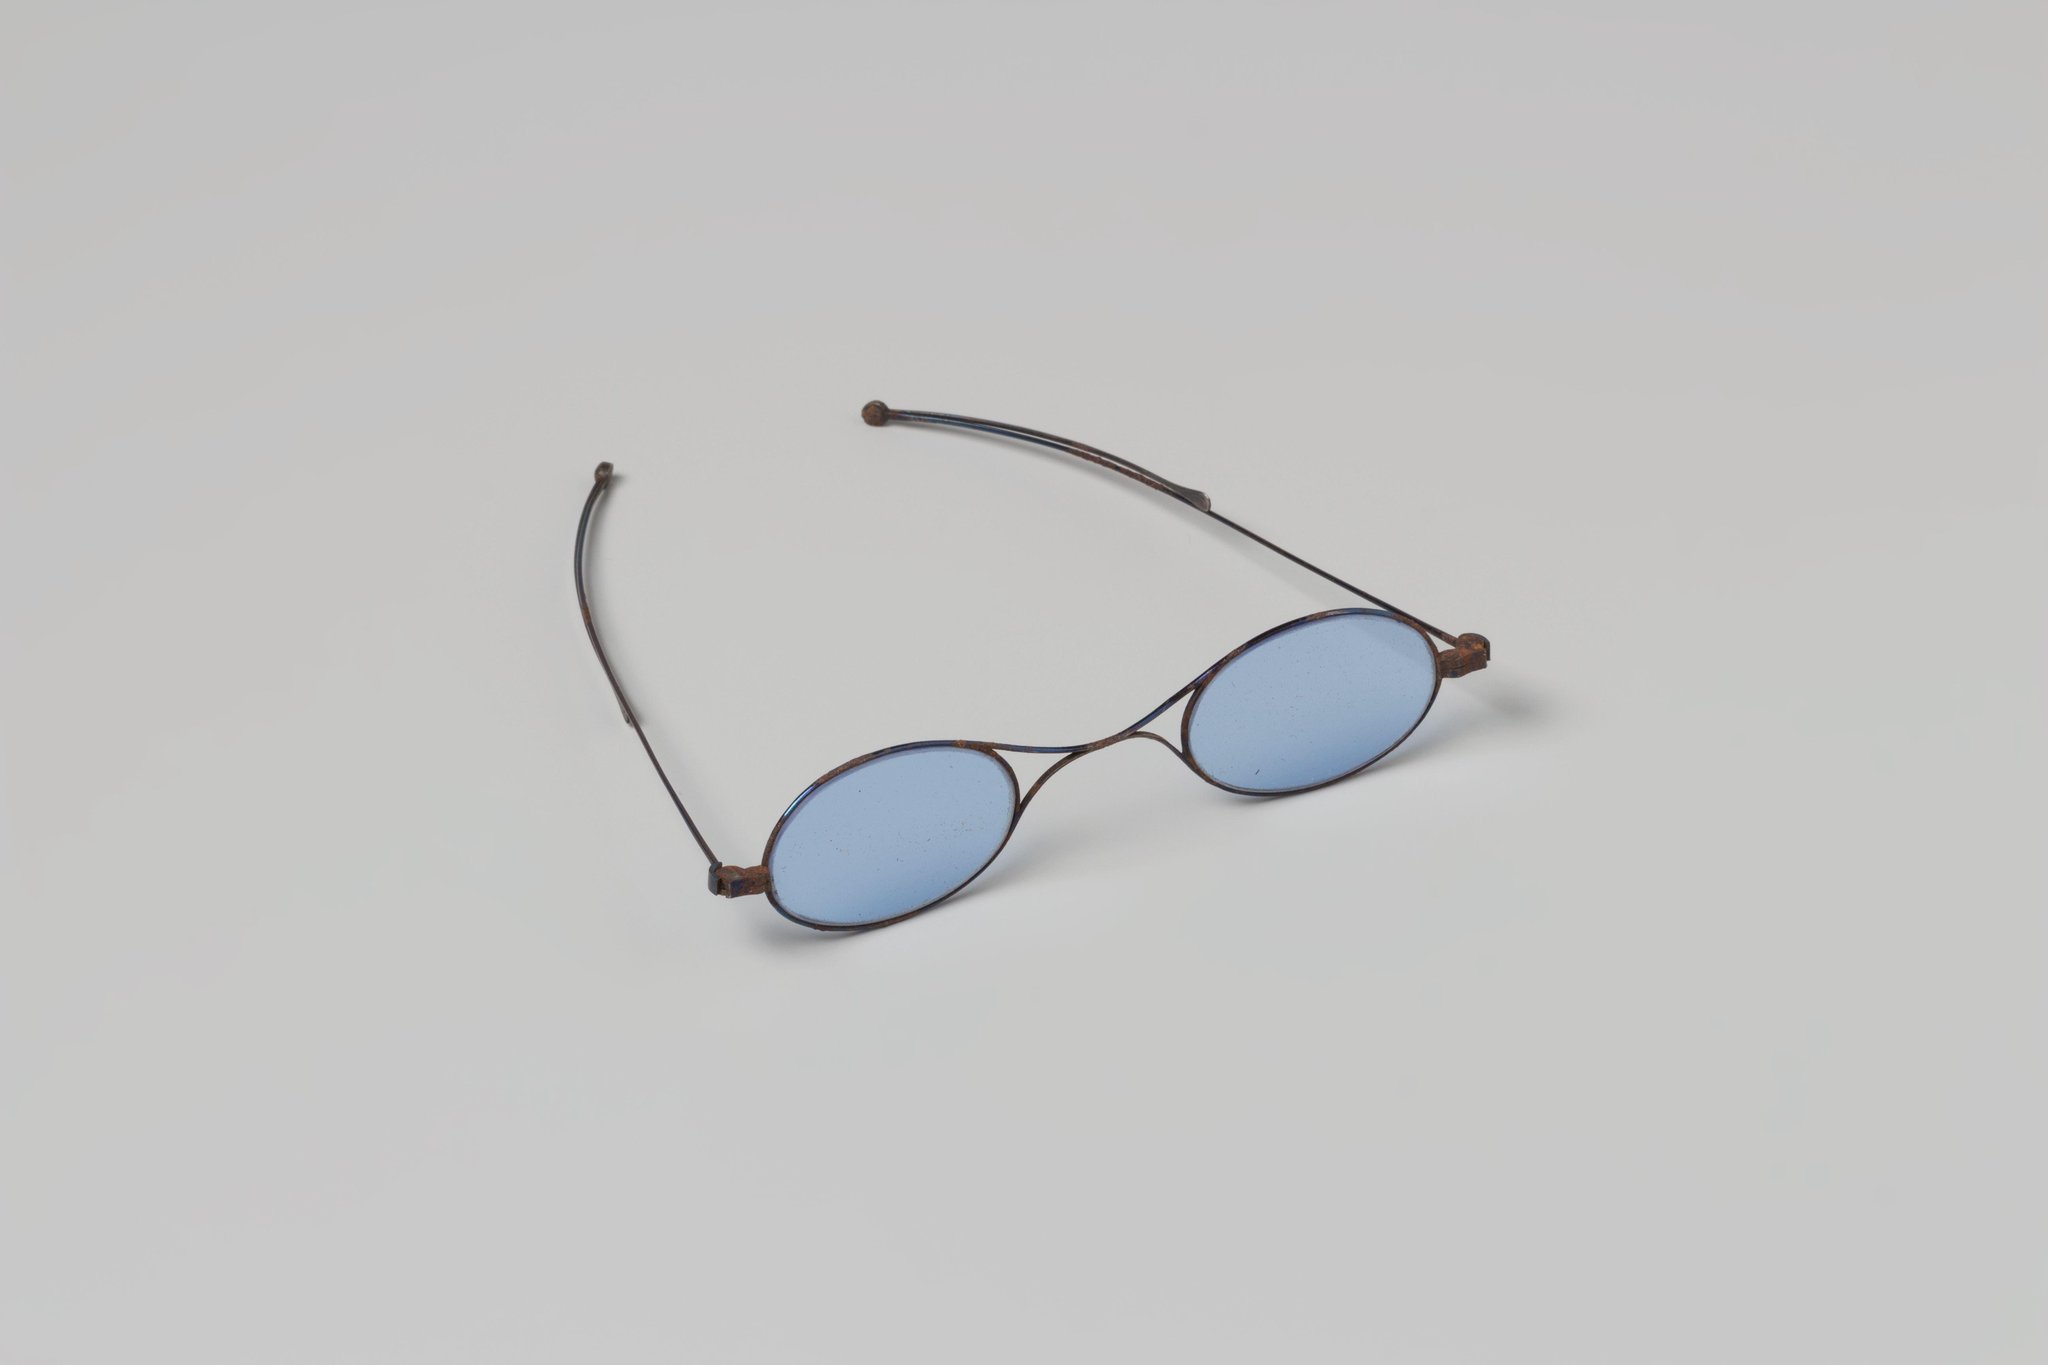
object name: spectacle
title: Bril van blauw staal met ovale blauwe brillenglazen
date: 1830-1860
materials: glass, steel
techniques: forging, grinding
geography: amsterdam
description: Bril met ovale blauwe glazen in blauw stalen, scharnierend montuur. Uiterst dun montuur met dubbele neusbrug en in de benen rechte, dichtklappende verlengstukken.